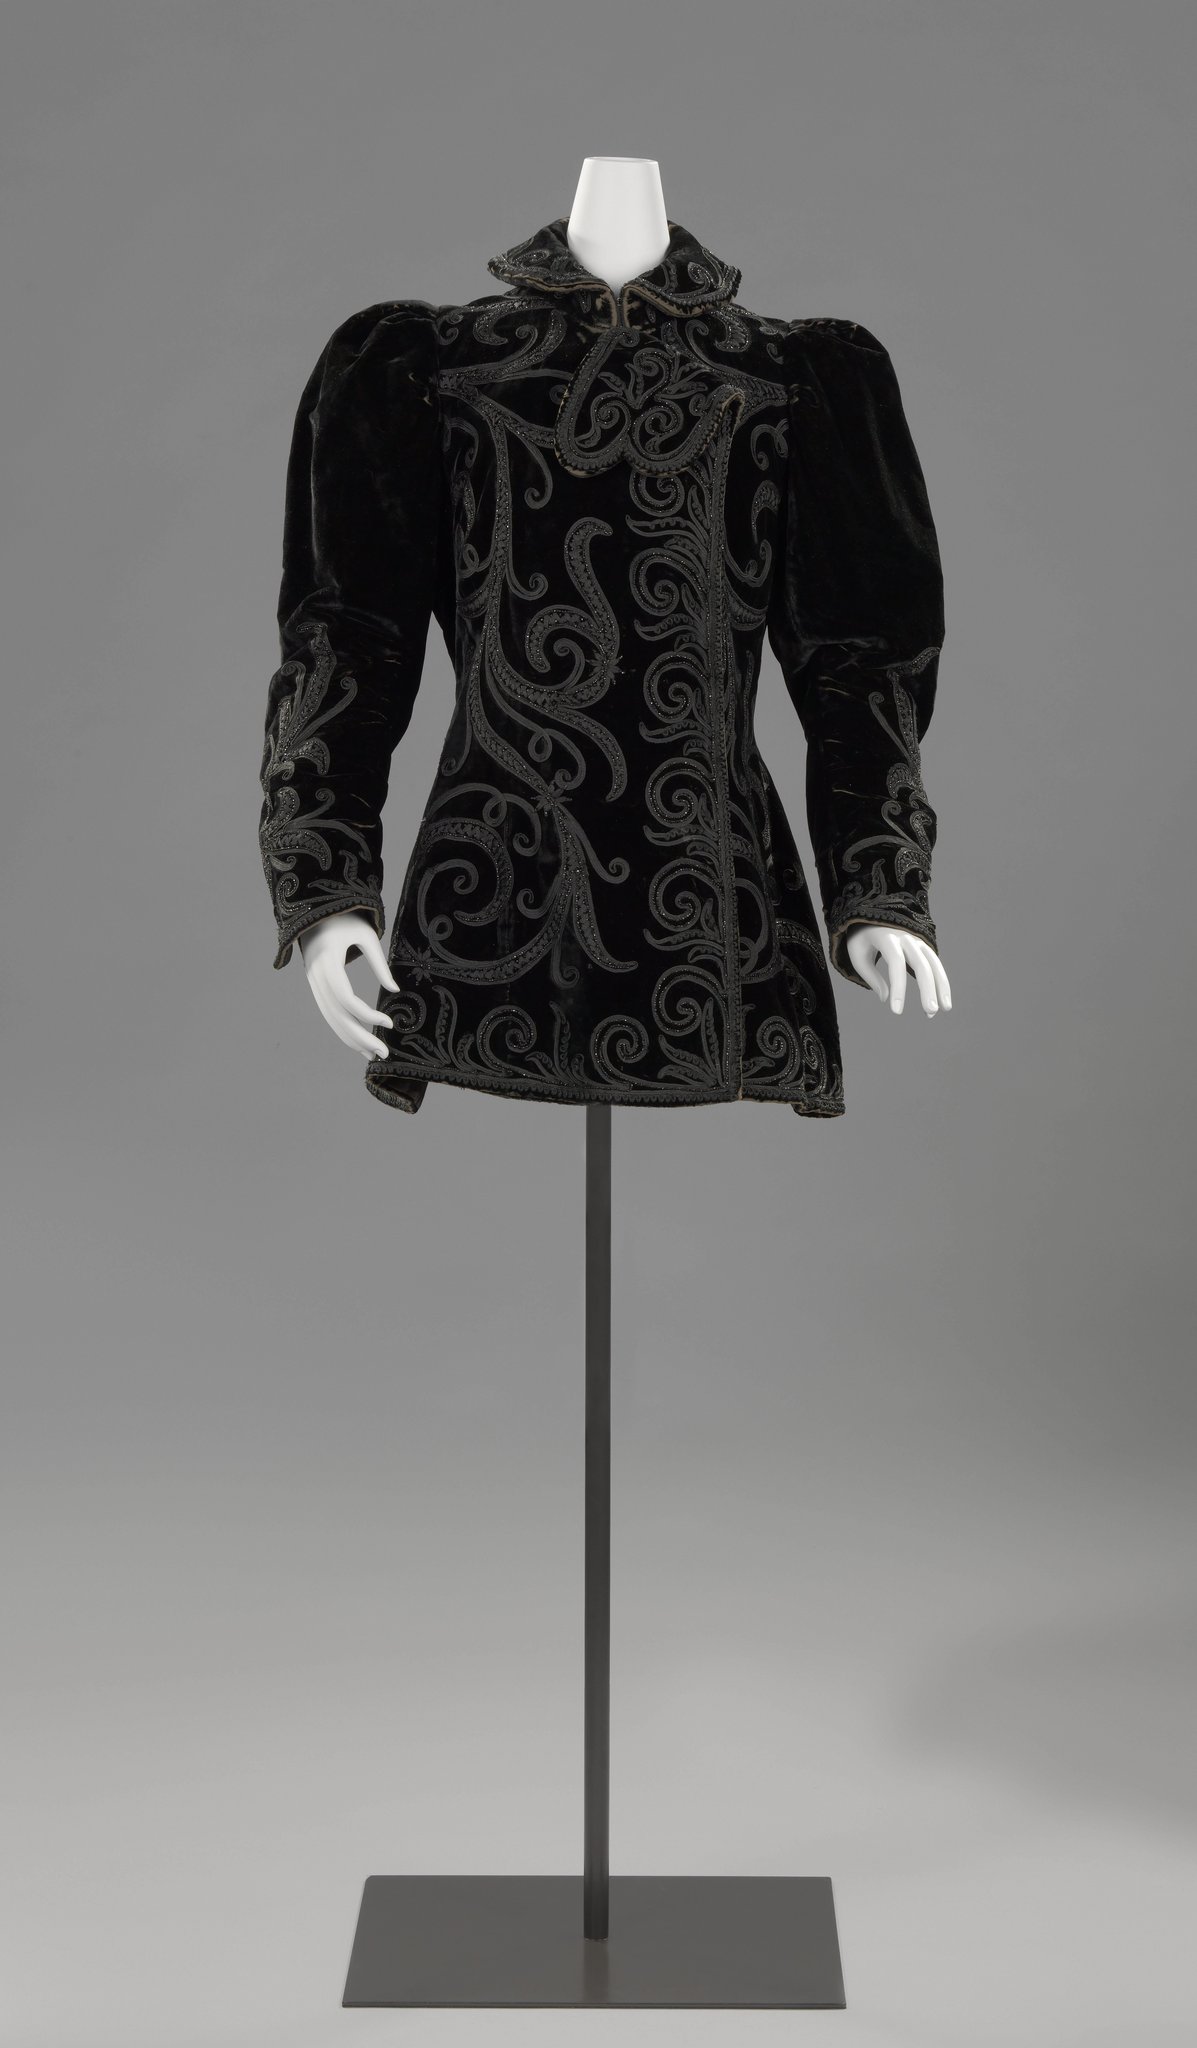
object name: womenswear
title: Paletot coat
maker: Anonymous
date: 1898-1899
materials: cotton, jet, silk, velvet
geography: netherlands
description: In the second half of the 19th century short and calf-length tailored sleeved coats were often known by the French term paletot. The decoration on this paletot consists of an appliqué braid with jet beads, a semiprecious mineral. The stylised scrolling follows the flowing lines of Art Nouveau (Jugendstil) that emerged in the late 19th century.